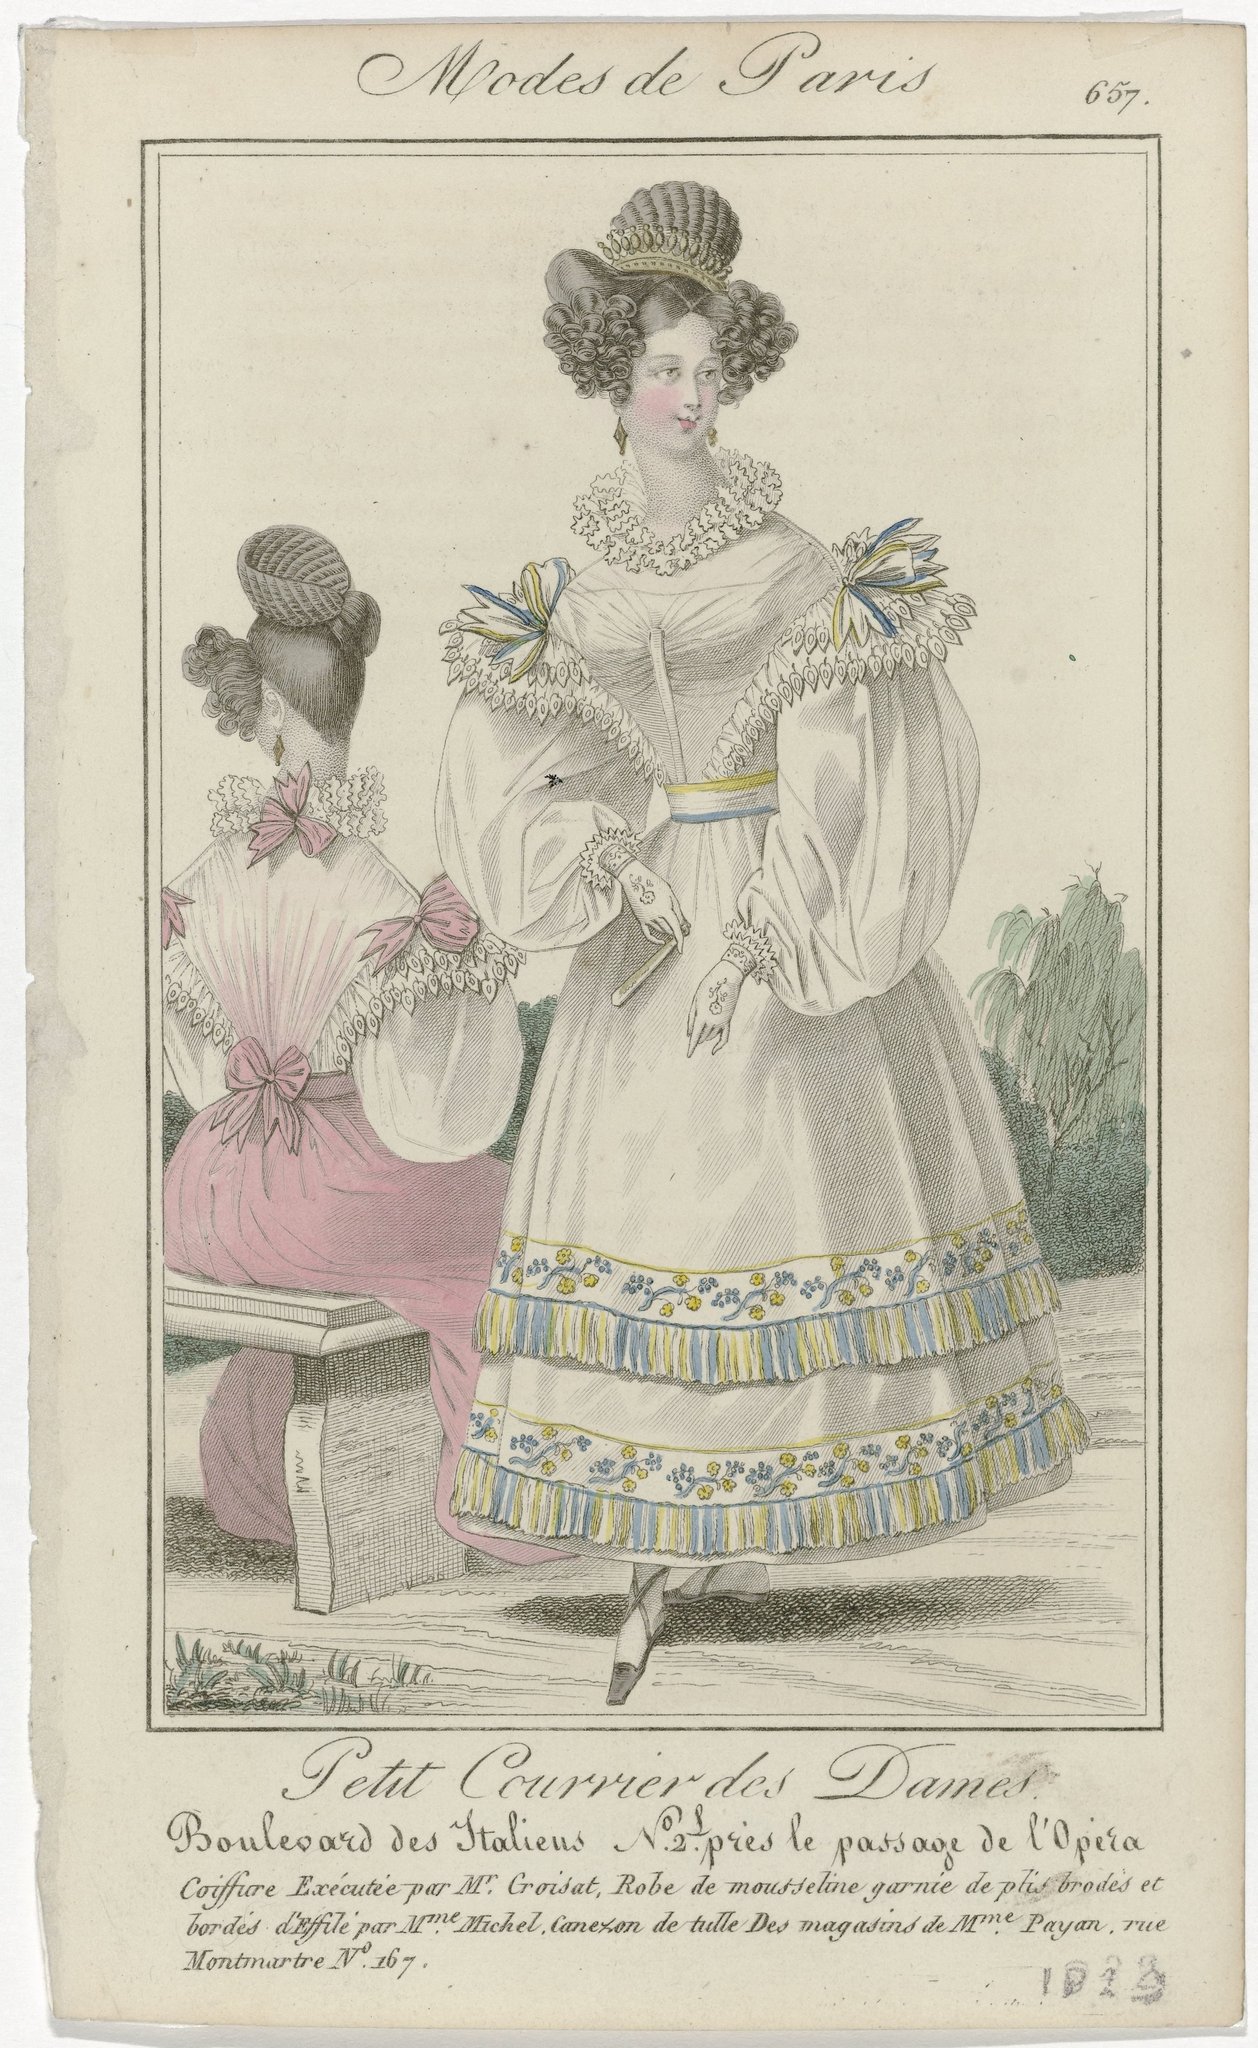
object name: fashion print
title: Petit Courrier des Dames, 1829, No. 657 : Coiffure Exécute par Mr.Croisat (...)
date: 1829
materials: paper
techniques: engraving, hand coloring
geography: paris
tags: ear-rings (+ women's clothes), embroidery (ornamentation) (+ women's clothes), styles of hairdress - aa - ~ women, fashion plates, dress, gown (+ women's clothes), fan (+ women's clothes)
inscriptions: caption: ‘Coiffure Exécute par Mr.Croisat, Robe de mousseline garnie de plis brodés et bordés d'Effile par M.me Michel, Canezou de tulle Des magasins de M.me Payan, rue Montmartre No. 167.’, title: ‘Petit Courrier des Dames.’, address: ‘Boulevard des Italiens No.2 près le passage de l'Opèra.’, title: ‘Modes de Paris.’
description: 'Coiffure' uitgevoerd door Mr Croisat. Japon van mousseline versierd met borduurwerk en franjes, door Michel. 'Canezou' van tule uit de winkels van Mme Payan. Verdere accessoires: oorbellen, handschoenen, waaier, platte schoenen met gekruiste banden. Prent uit het modetijdschrift Petit Courrier des Dames (1821-1868).